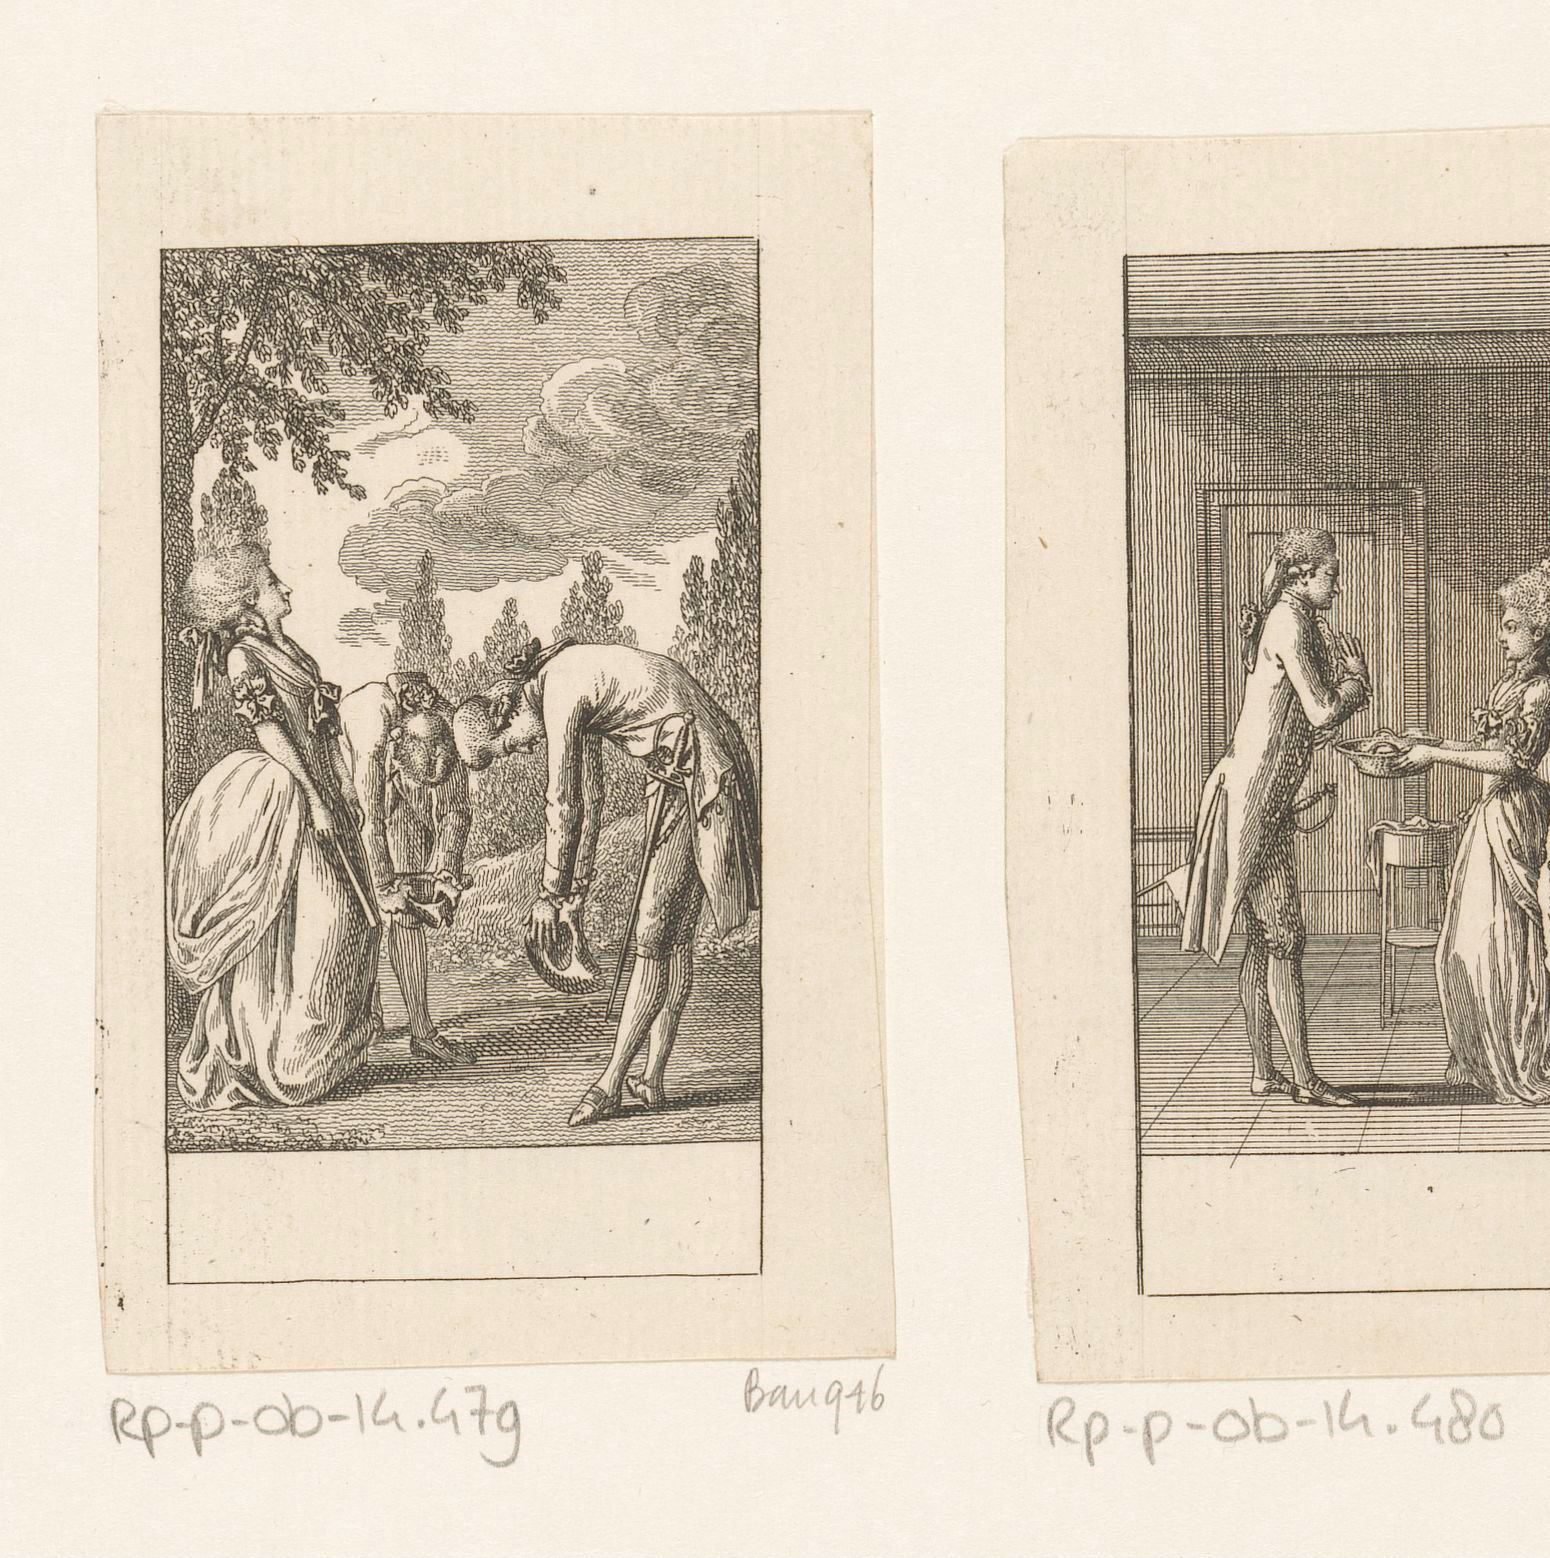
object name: print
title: Complimenteuze dwaasheid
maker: daniel nikolaus chodowiecki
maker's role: draughtsman, print maker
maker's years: 1726-1801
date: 1782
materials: paper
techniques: etching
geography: berlin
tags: admiration, head bent forward; bowing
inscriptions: collector's mark: Lugt 2228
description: Vervaardigd voor Sancta Clara's 'Centifolium Stultorum'. Latere staat gebruikt voor: Goettinger Taschen Calender vom Jahr 1783. bey Joh. Chr. Dietrich. Göttingen: Georg Christoph Lichtenberg, 1782.